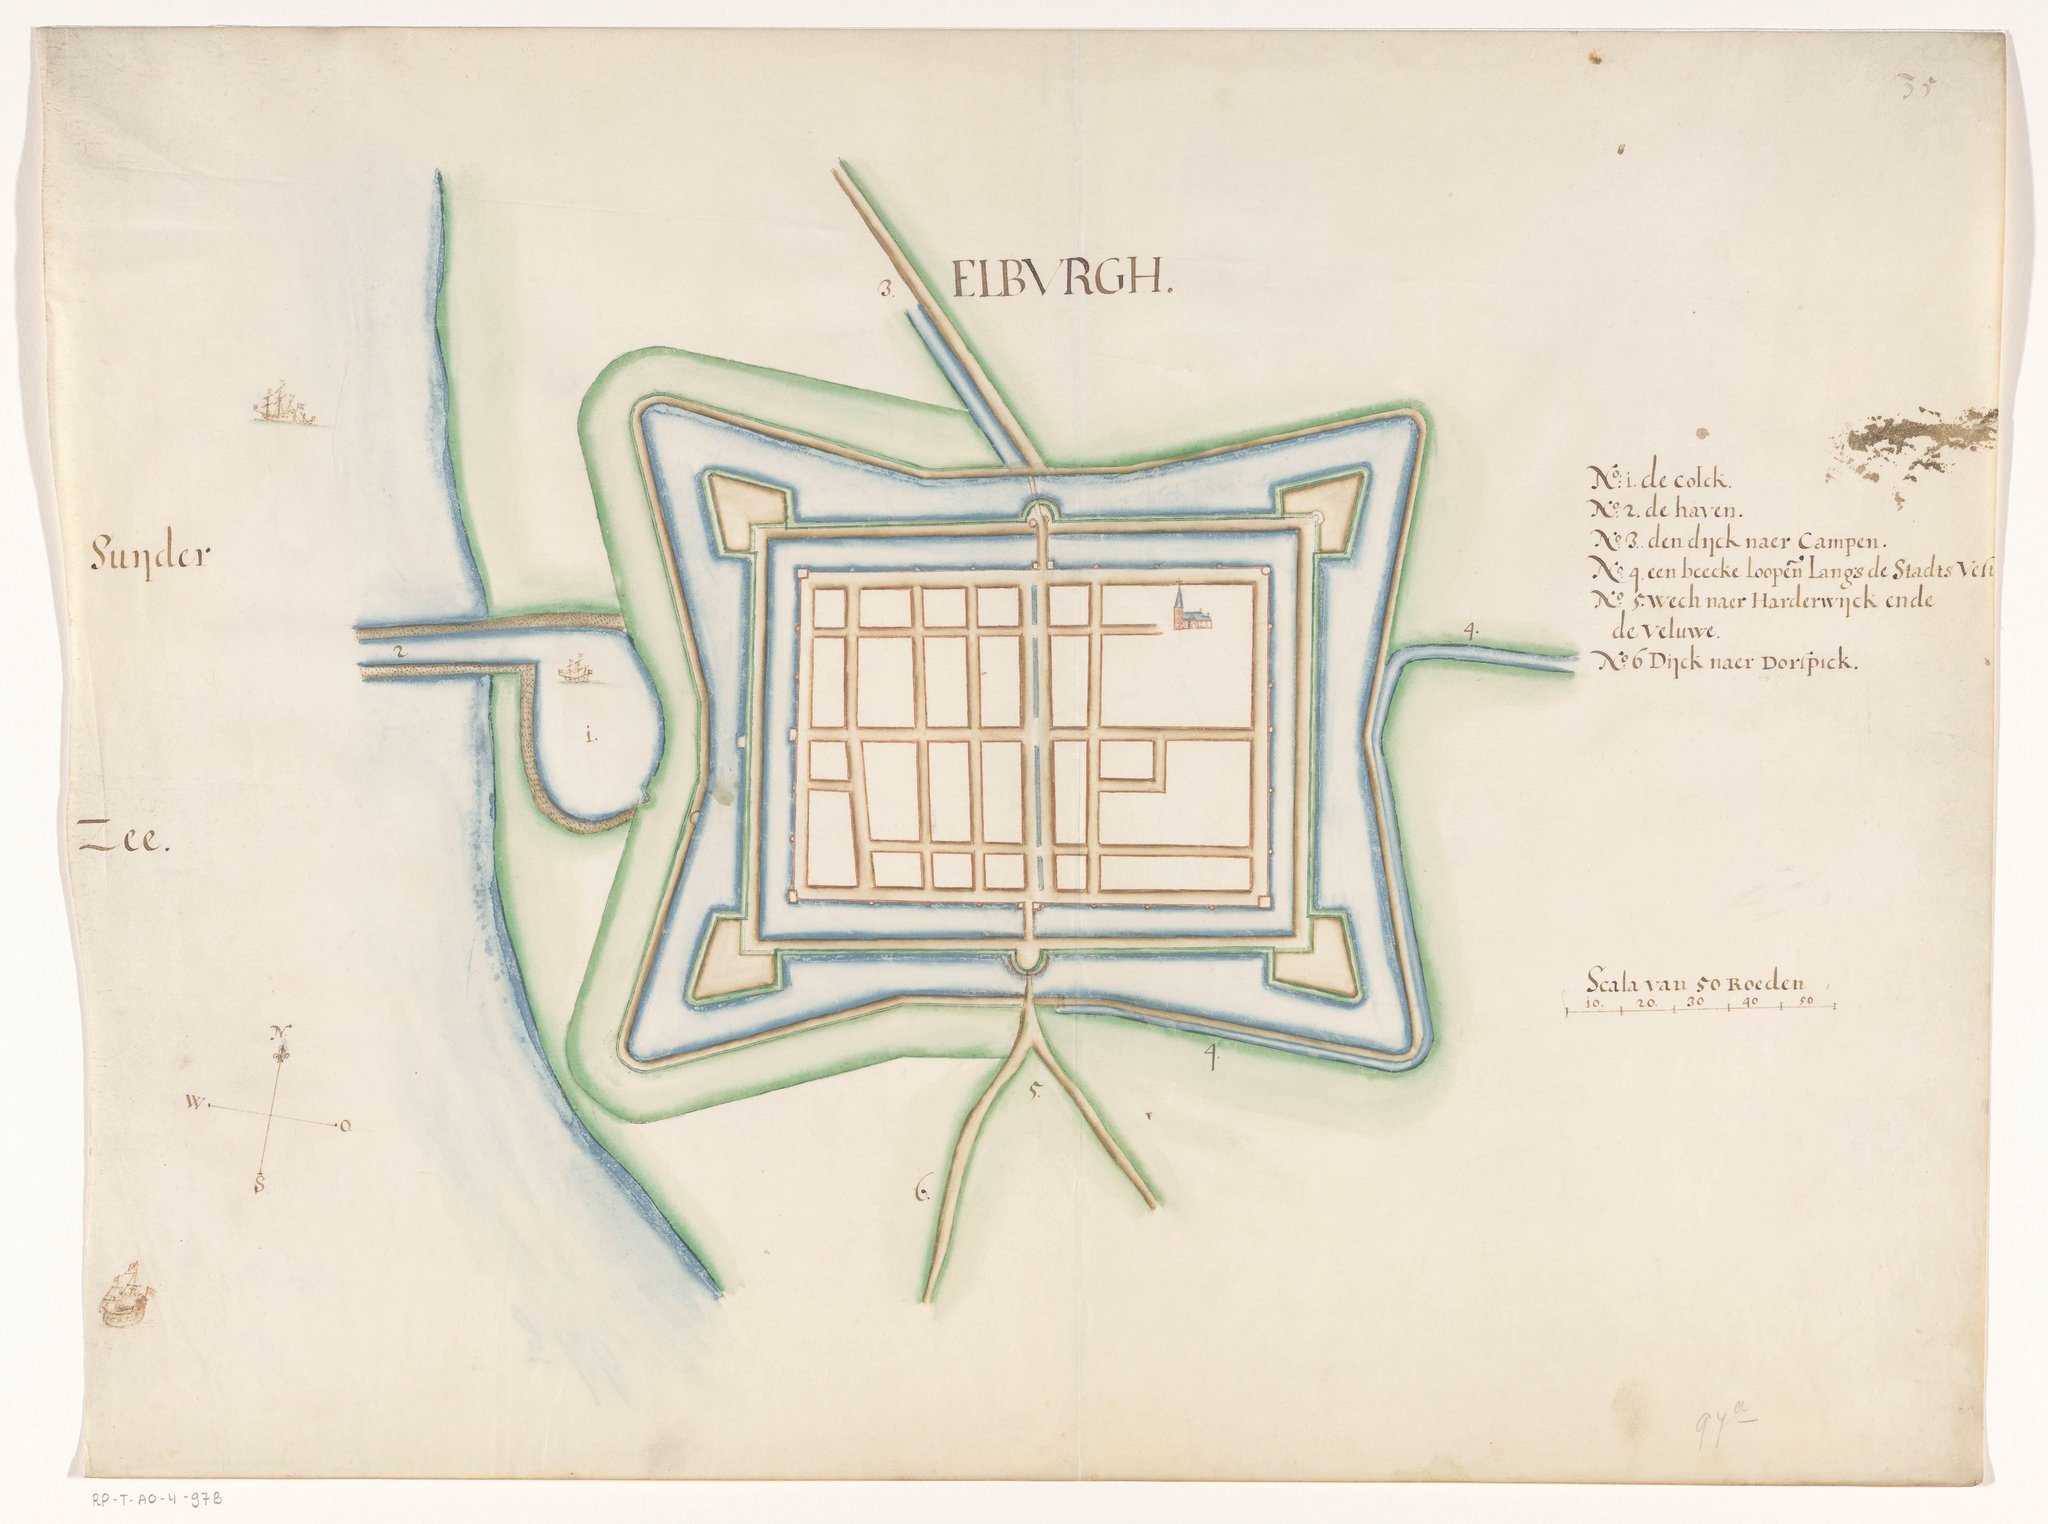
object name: area plan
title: Elburgh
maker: Anonymous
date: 1650-1799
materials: ink, parchment, watercolor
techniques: brush, pen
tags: fortress, maps of cities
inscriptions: check stamp: ‘Archief Ministerie van Oorlog Afdeeling Genie’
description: Rechts een legenda, daaronder een schaalstok: Scala van 50 roeden.